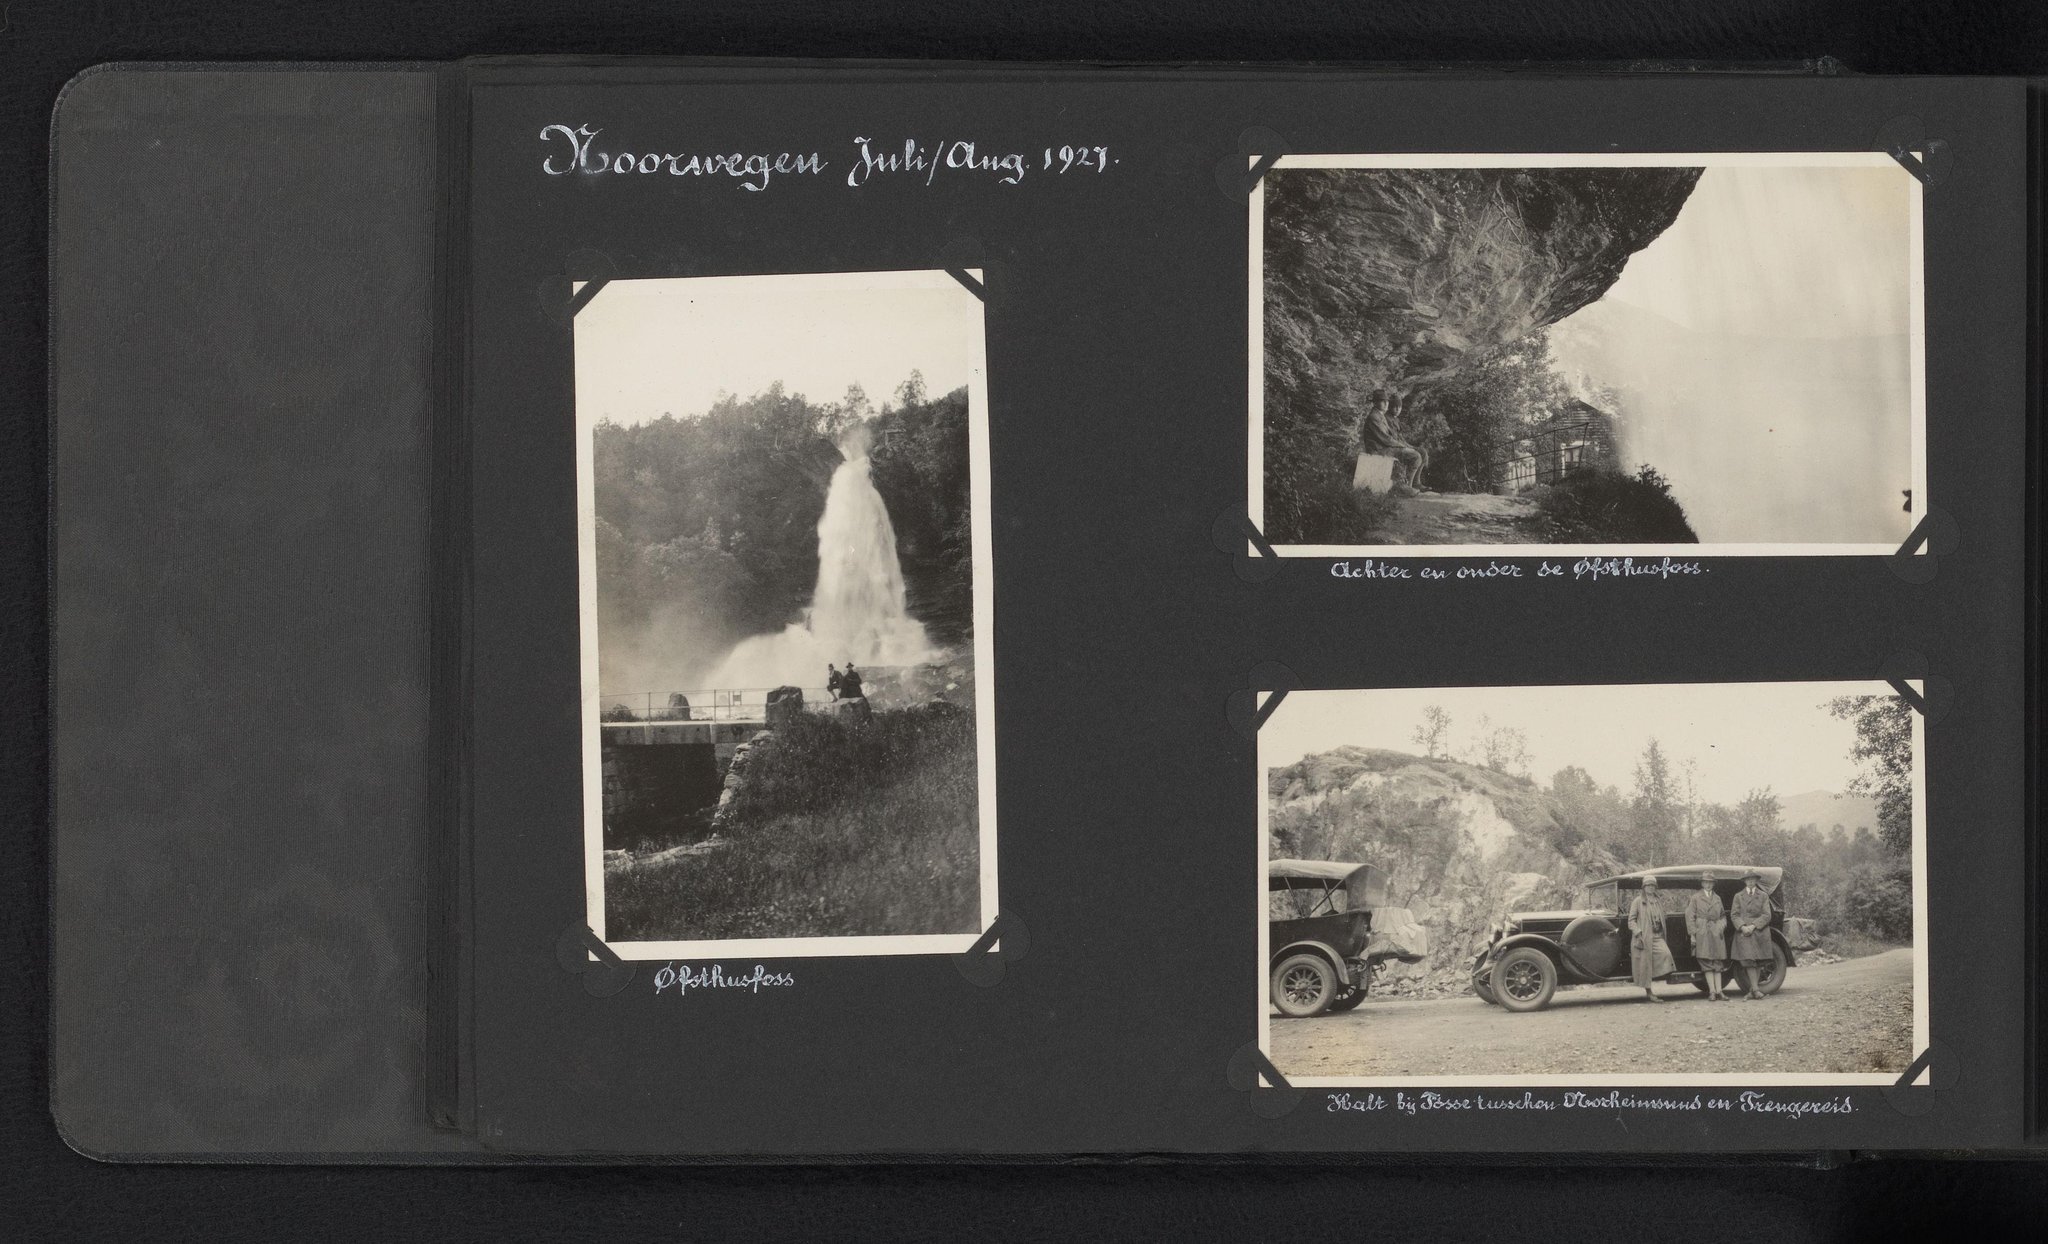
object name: album leaf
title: Noorwegen Juli/Aug. 1927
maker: hendrik herman van den berg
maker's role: amateurfotograaf, jurist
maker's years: 1875-1944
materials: paper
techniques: gelatin silver print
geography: norway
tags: the hague, caroline louise van den berg-van den berg, amsterdam, carel frederik van den berg (cay), frank willem van den berg (1912-1998), family group, especially parents with their child(ren), waterfall, automobile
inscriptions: inscription: ‘Øfsthusfoss’, inscription: ‘Halt bij Fosse tusschen Norheimsund en Trengereid’, inscription: ‘Acher en onder de Øfsthusfoss’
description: Deze foto's maken deel uit van een album.